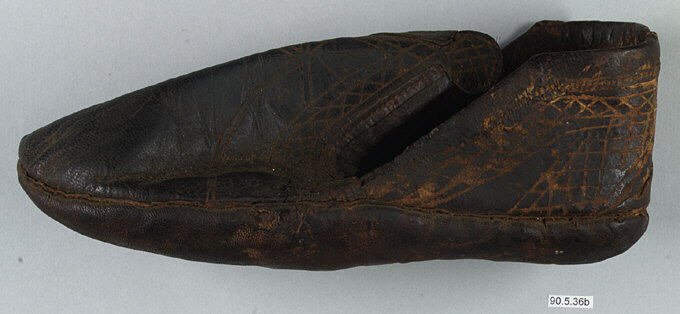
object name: boot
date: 501-700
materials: leather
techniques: incising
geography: egypt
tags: boots